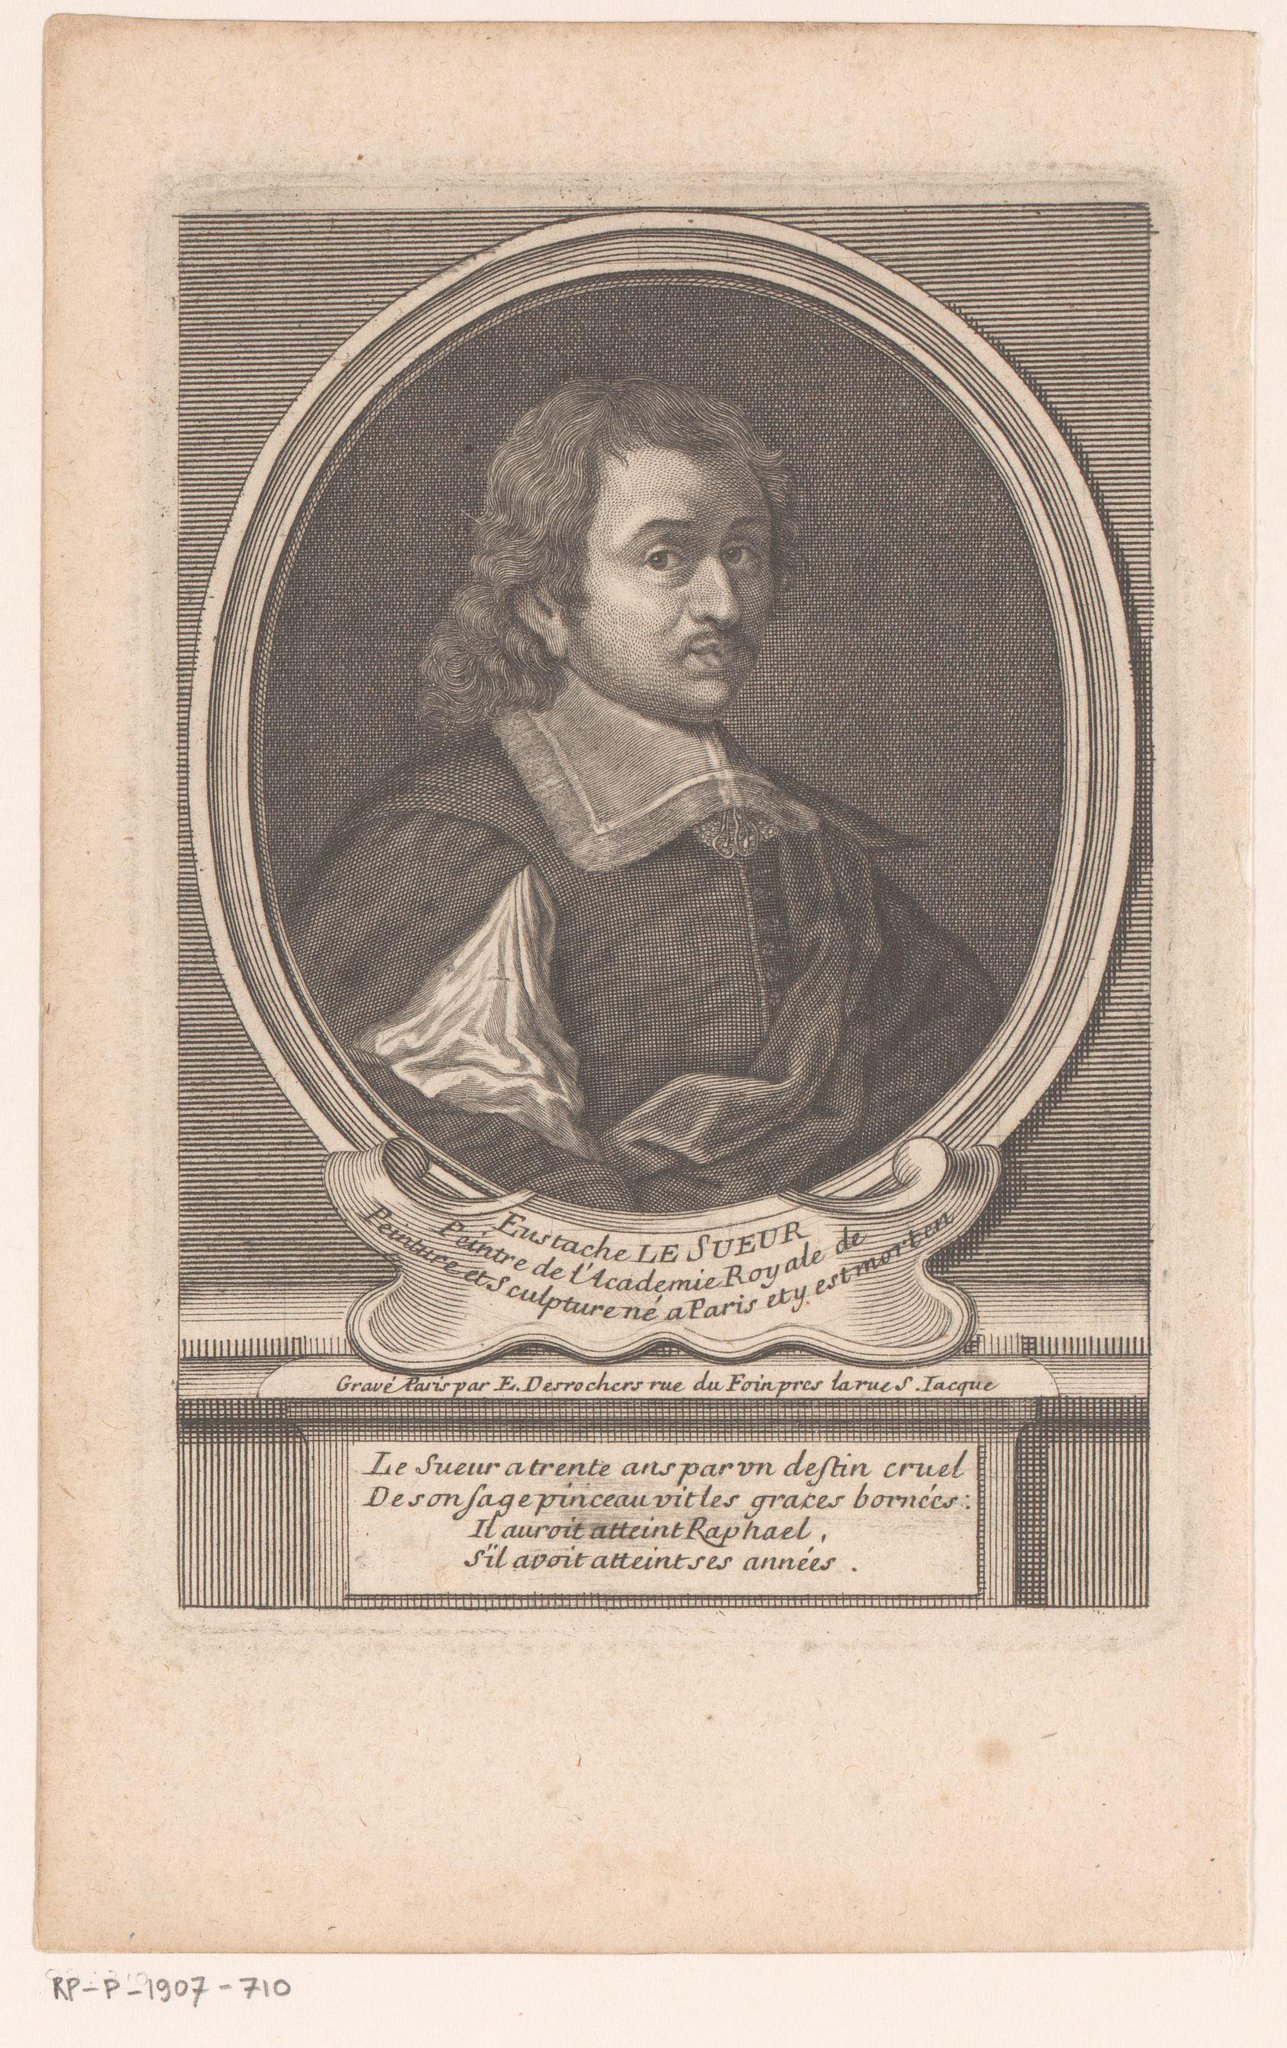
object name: print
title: Verzameling portretten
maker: étienne desrochers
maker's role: print maker, publisher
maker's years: 1668-1741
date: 1726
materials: paper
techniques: engraving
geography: paris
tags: eustache lesueur, historical persons, portrait, self-portrait of artist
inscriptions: collector's mark: Lugt 2228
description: Behoort waarschijnlijk tot een serie portretten, grotendeels door Etienne Desrochers, getiteld: 'Recueil de portraits de personnes qui se sont distinguées tant dans les Armes que dans Belles-Lettres et les Arts, comme aussi la famille royale de France et autres cours étrangères'. De serie werd initieel uitgegeven door Desrochers en aangekondigd in 'Mercure' in mei 1726, p. 985. Echter was Desrochers reeds enkele jaren eerder begonnen met het uitgeven van de serie. Na de dood van Desrochers werd de serie voortgezet door Gilles Edme Petit. Een latere staat werd uitgegeven door Jean François Daumont in Parijs.